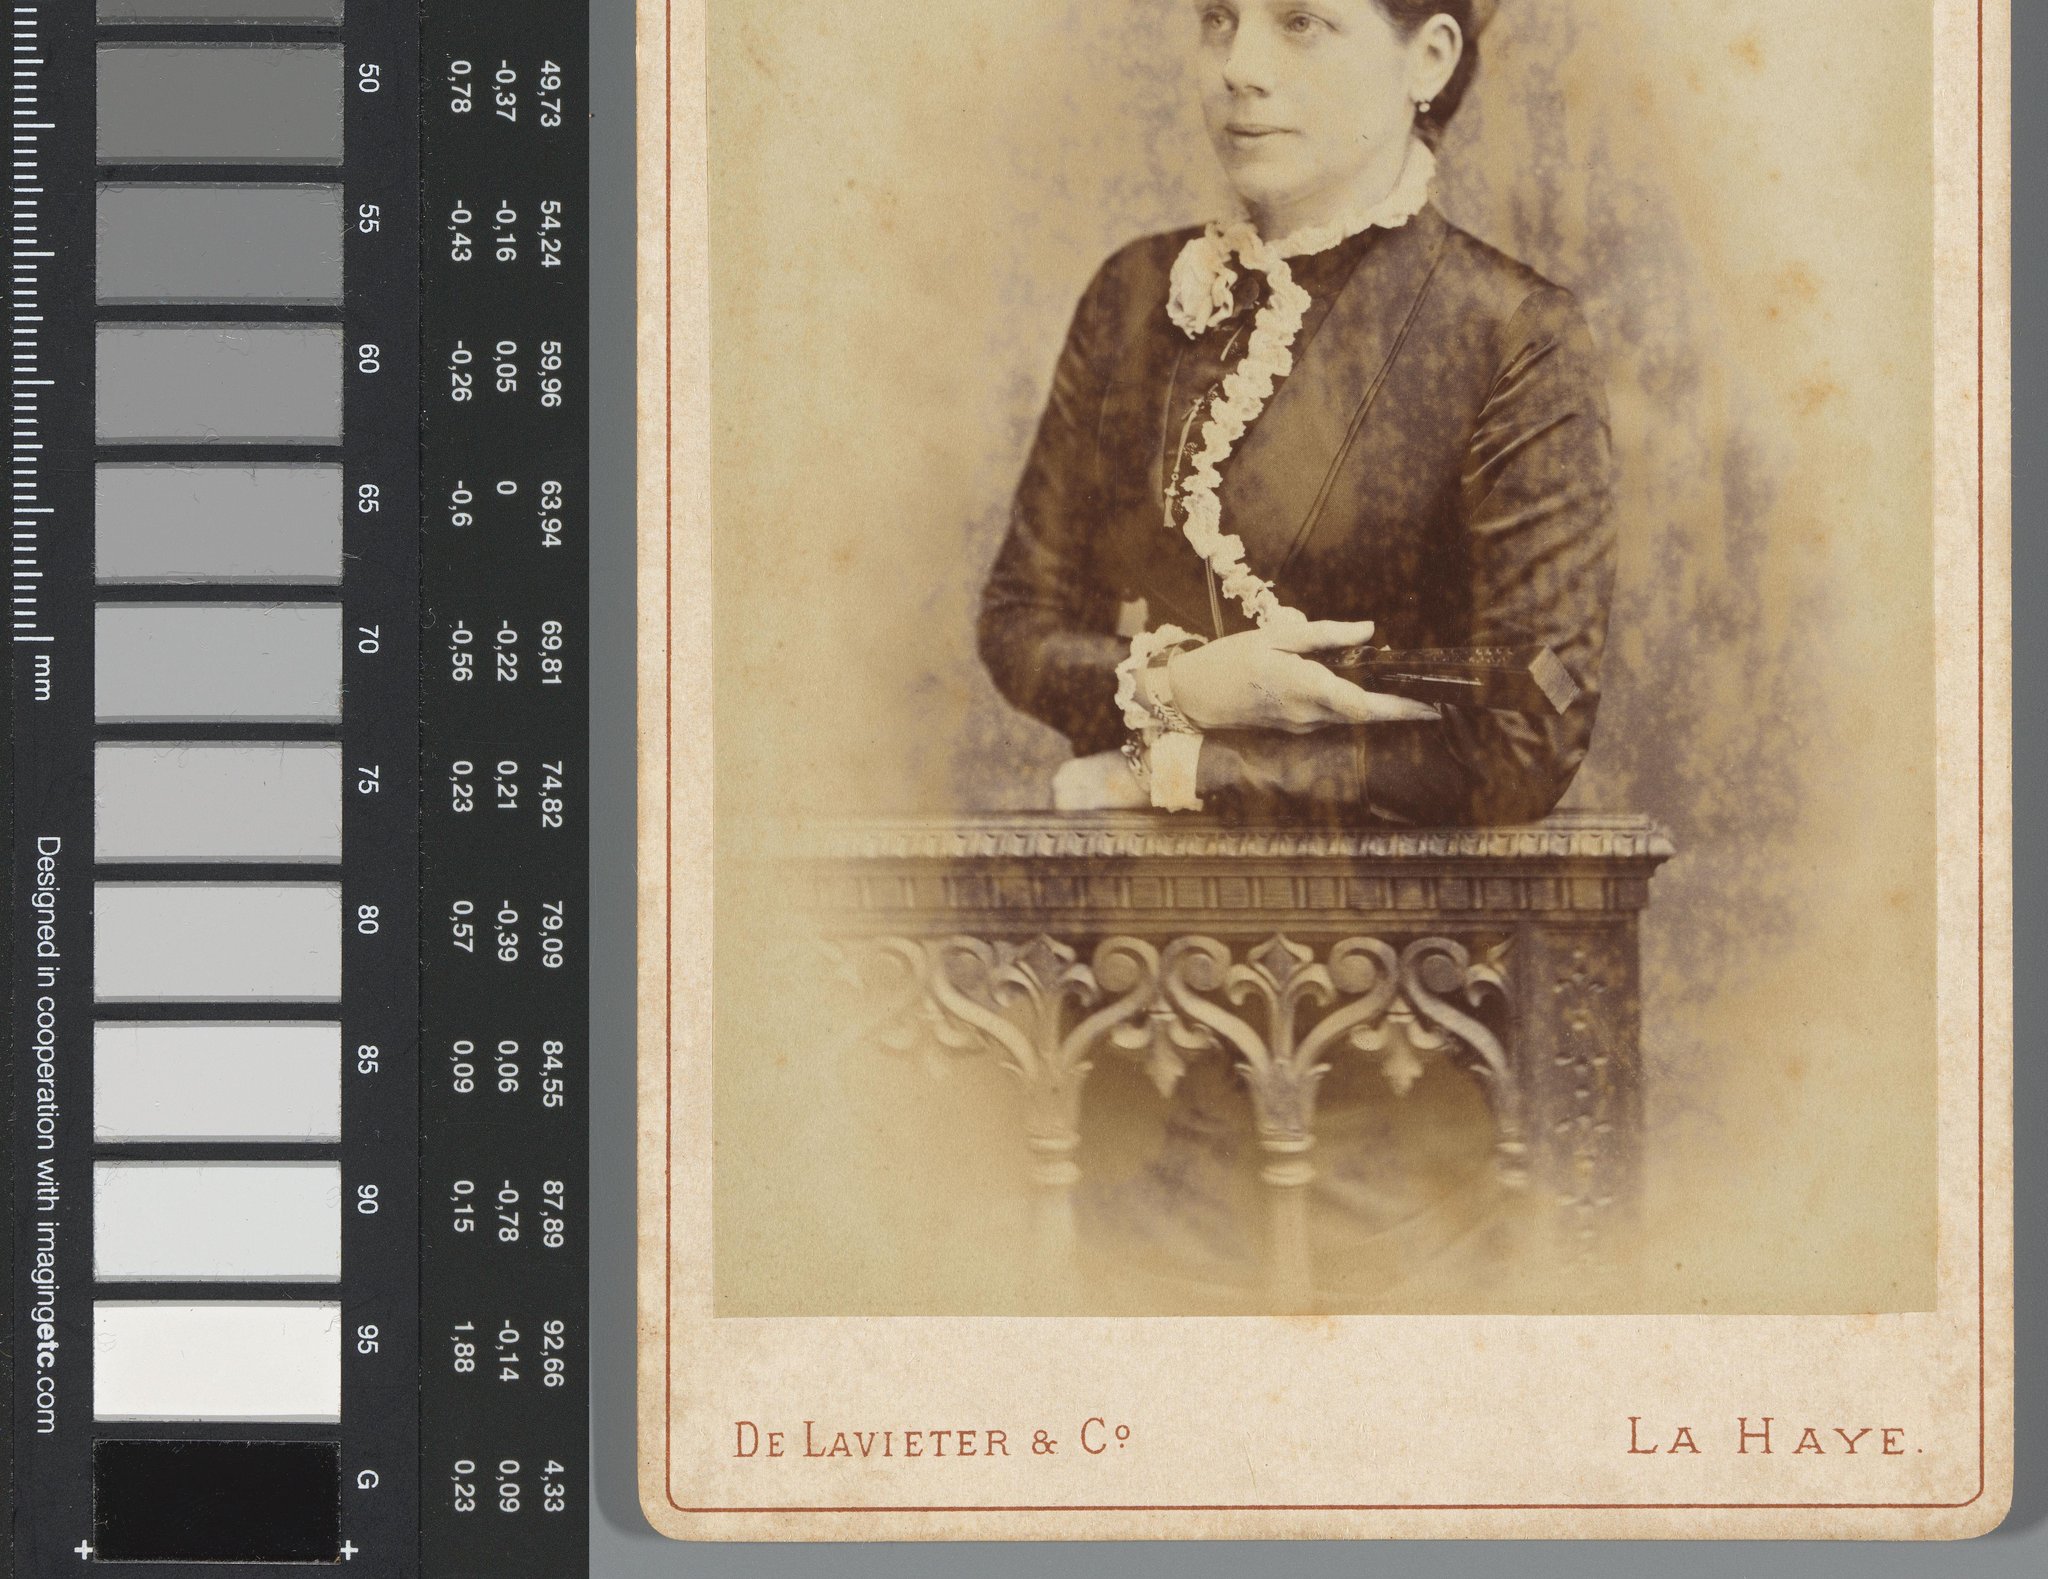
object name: cabinet photograph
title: Studioportret van Carolina Frederika Holle, leunend op een hek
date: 1860-1870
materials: cardboard, photographic support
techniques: albumen print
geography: the hague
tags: amsterdam, carolina frederika van den berg-holle, the hague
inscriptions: name: ‘DE LAVIETER & Co LA HAYE.’, inscription, name: ‘DE LAVIETER & Co / PHOTOGRAPHES DE S. M. LE ROI, / ET DE SON ALTESSE ROYALE / LE PRINCE ALEXANDRE / DES PAYS-BAS. / LA HAYE.’